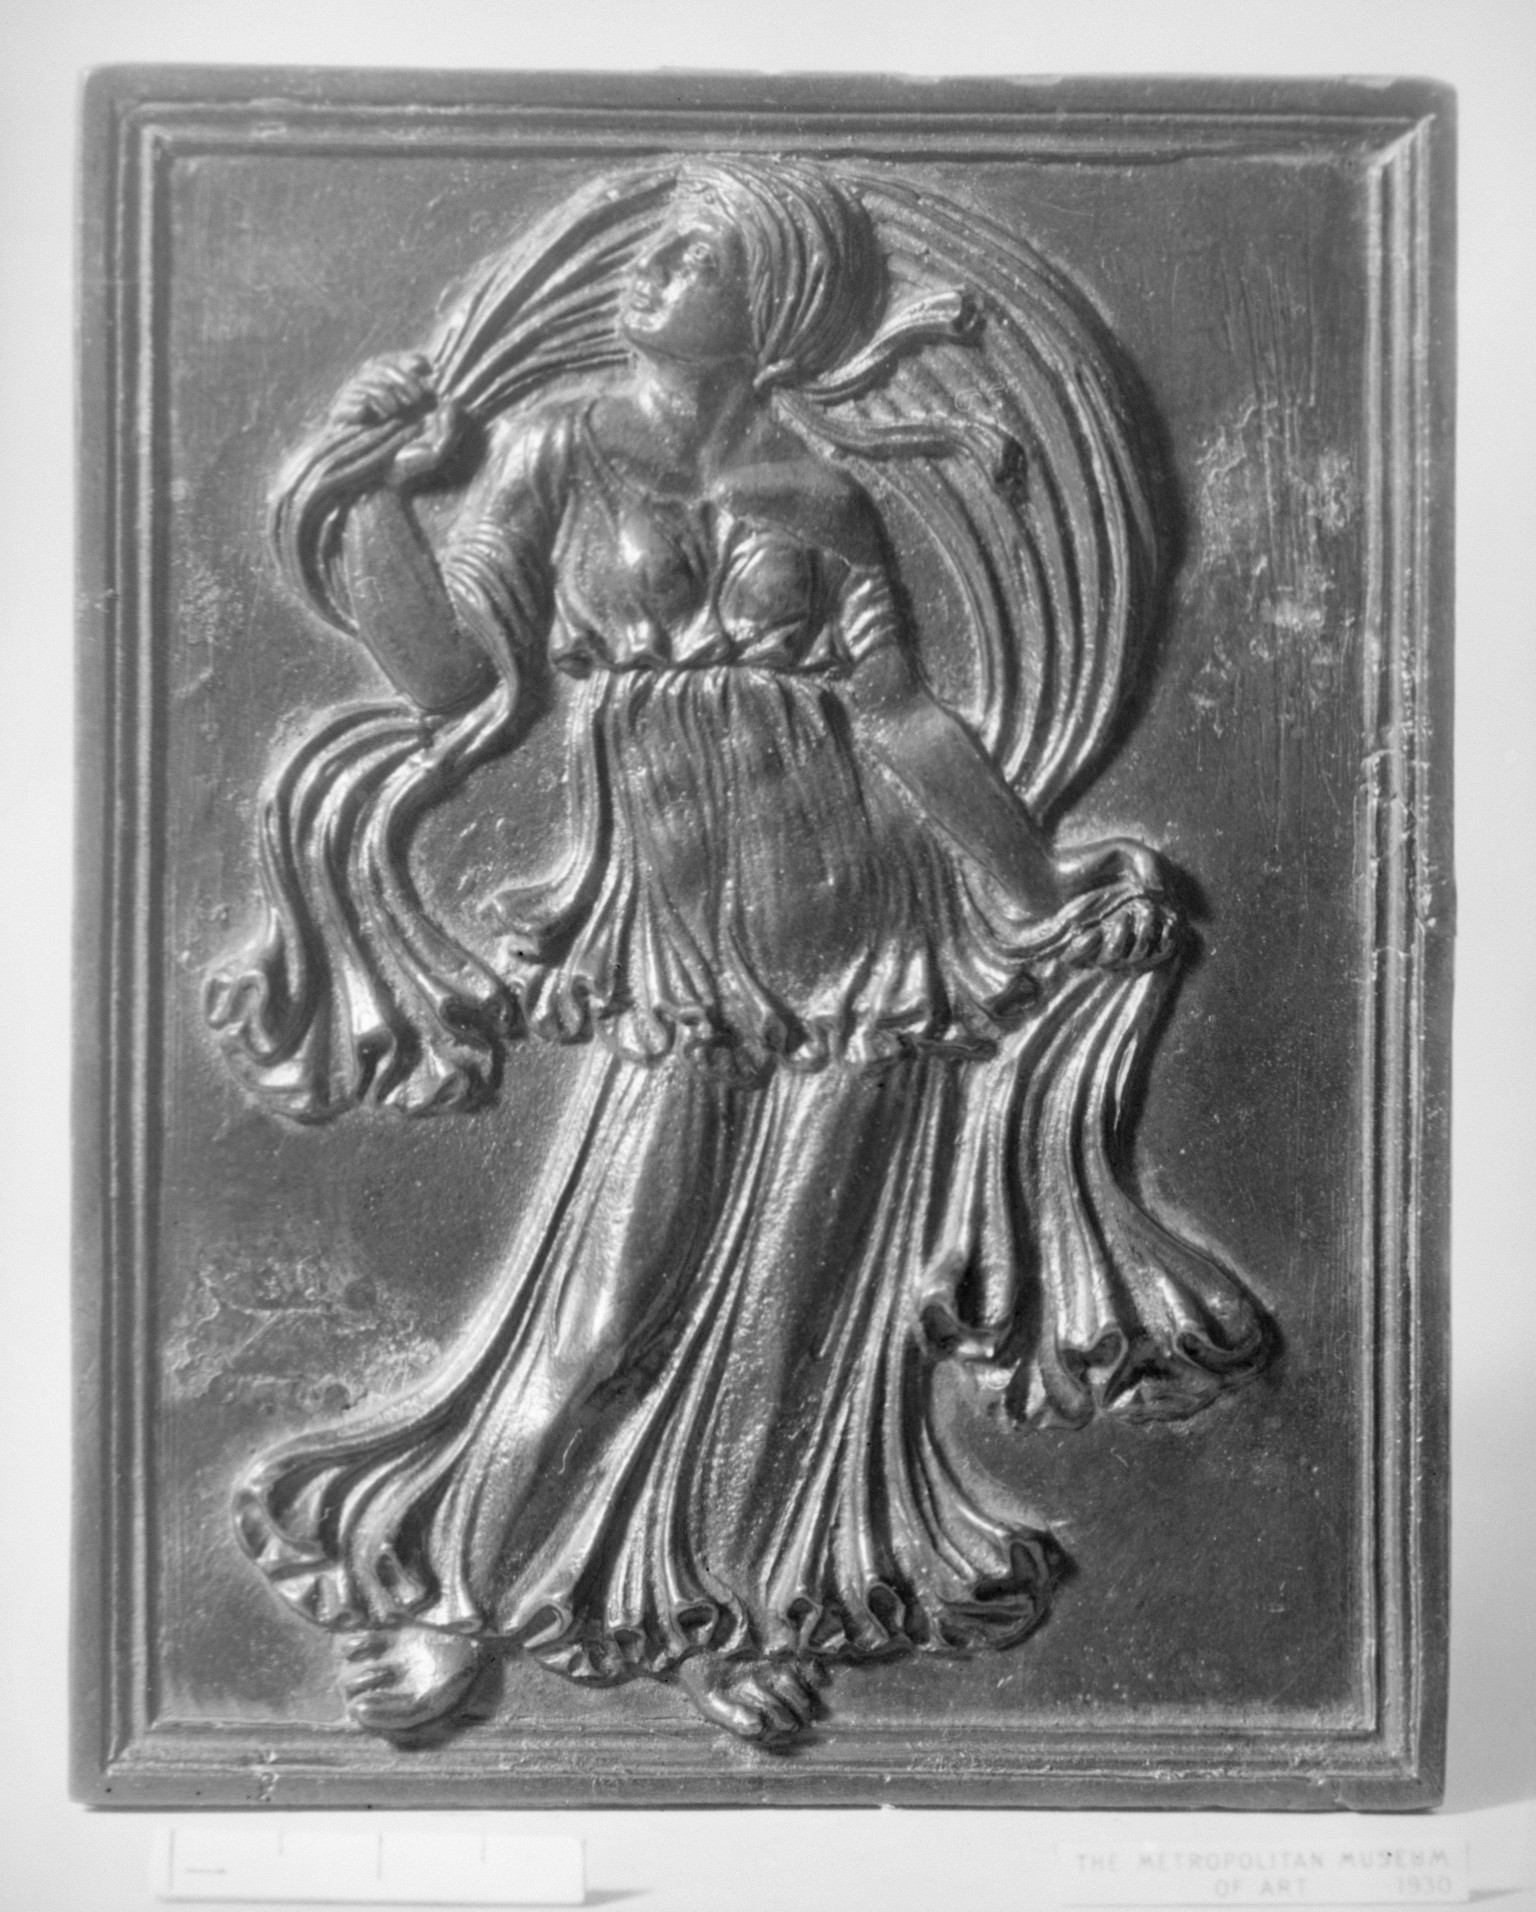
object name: plaquette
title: Bacchante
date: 1451-1500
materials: bronze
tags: women,bacchantes